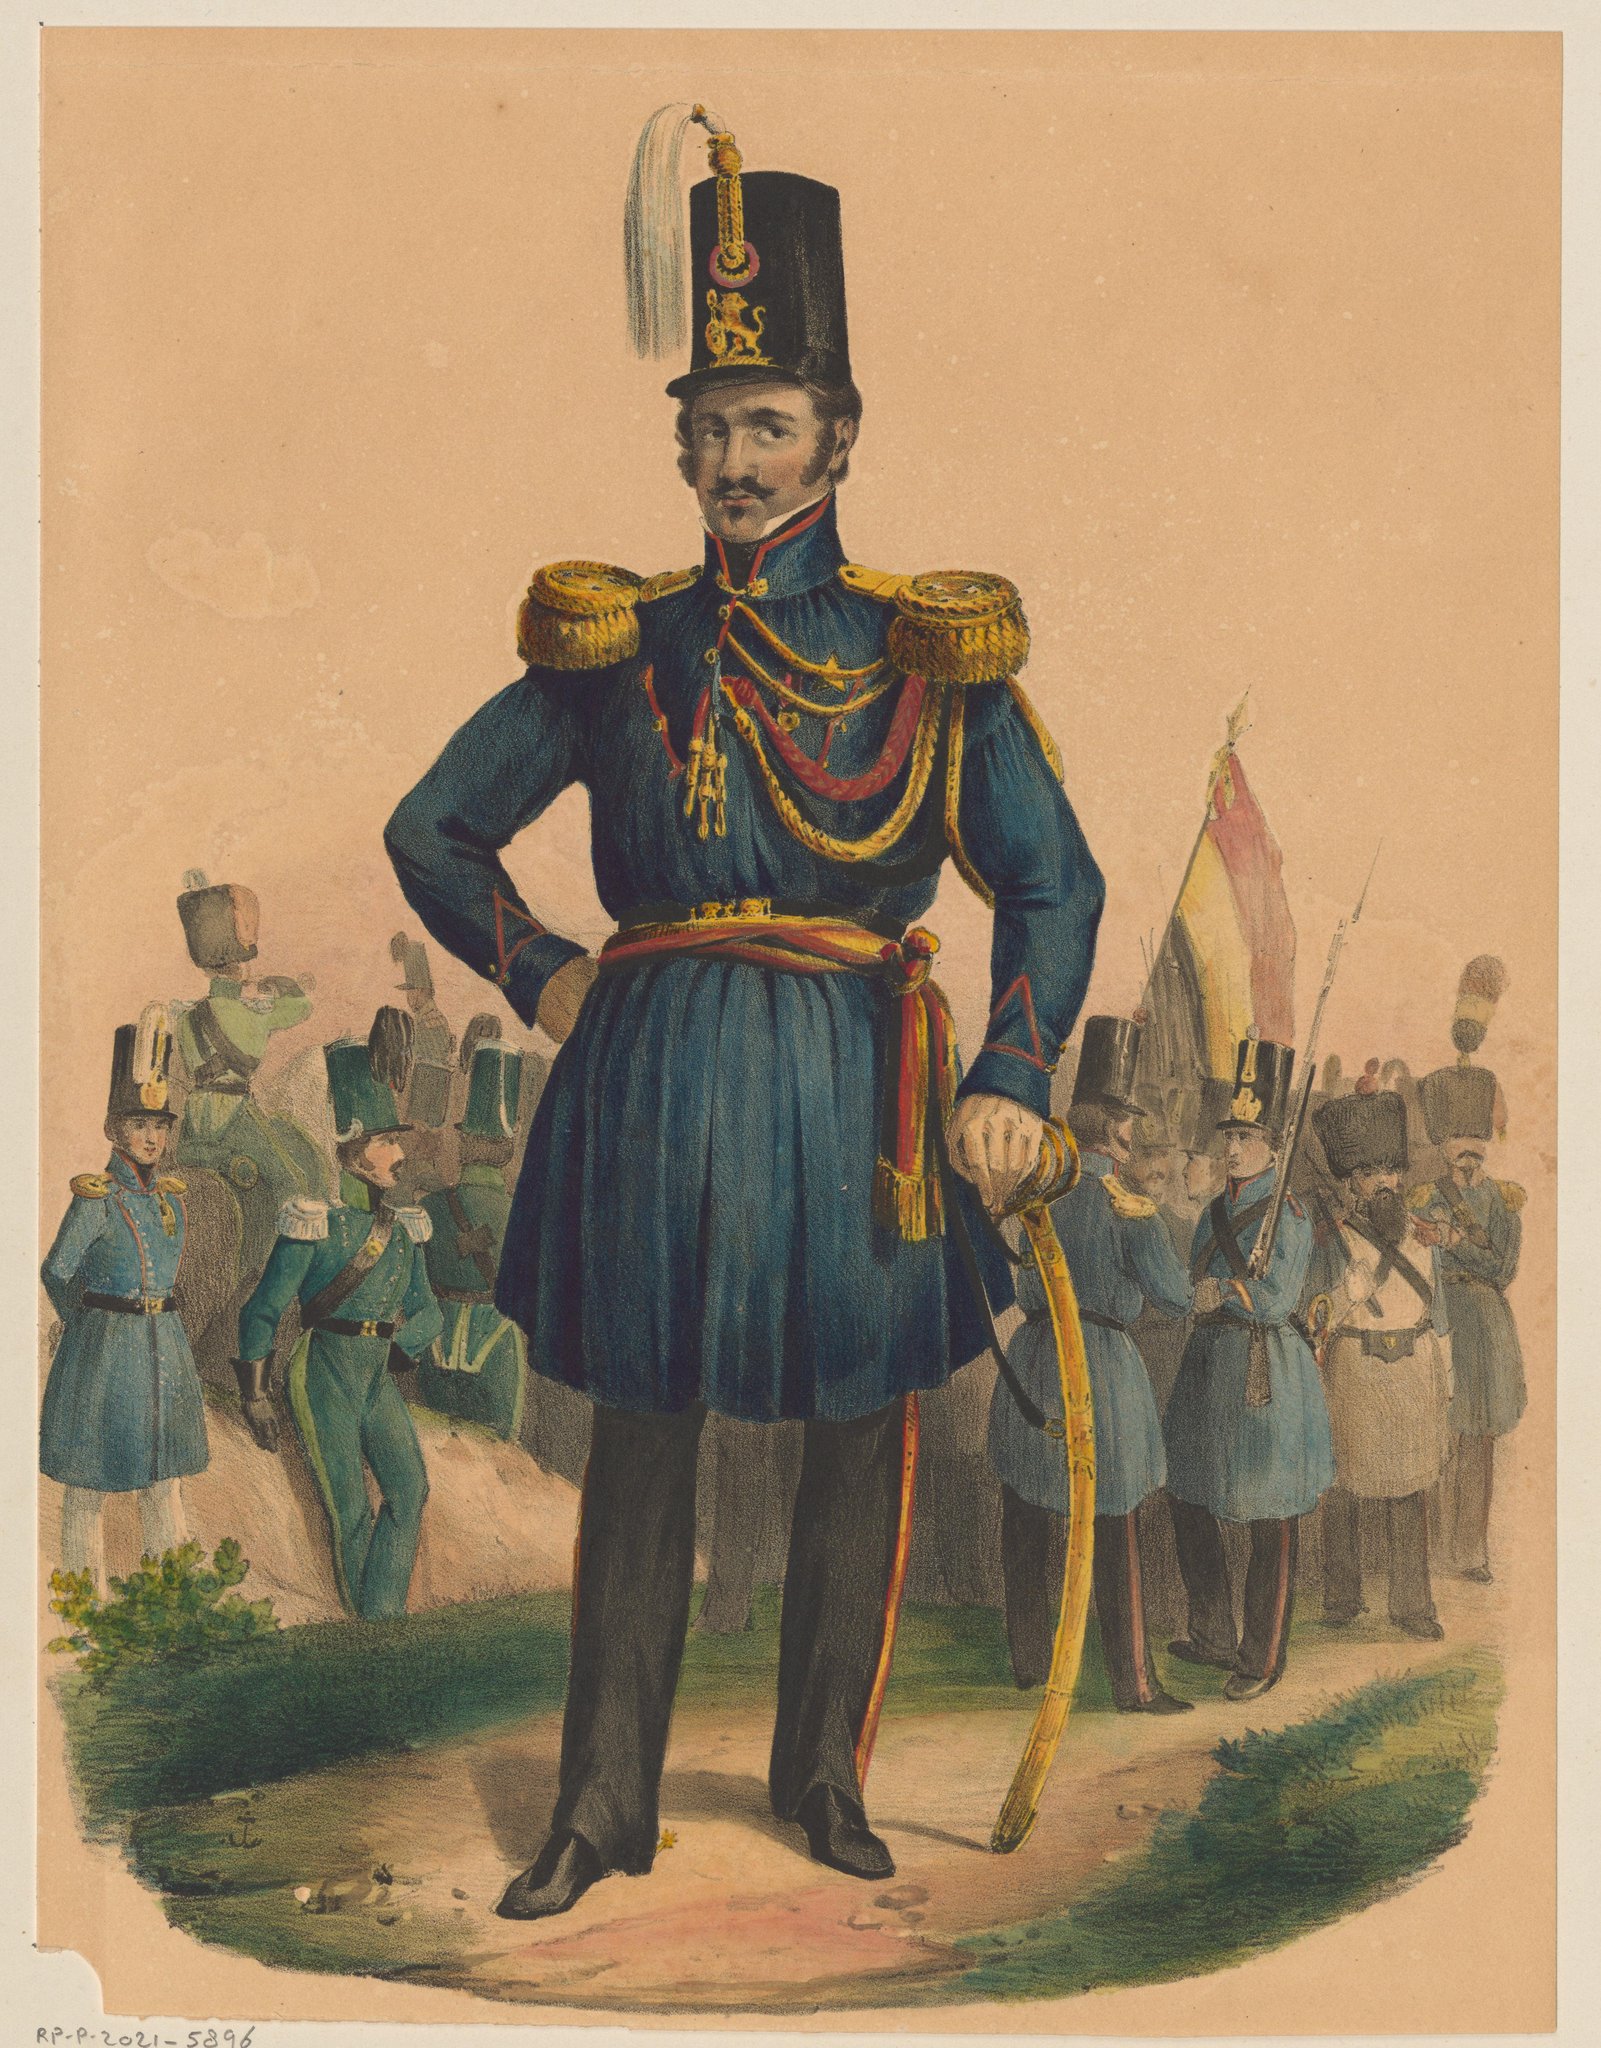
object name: print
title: Portret van Emmanuel van der Linden d'Hooghvorst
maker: Anonymous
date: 1830-1875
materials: paper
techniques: hand coloring, lithograph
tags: commander-in-chief, general, marshal, historical persons